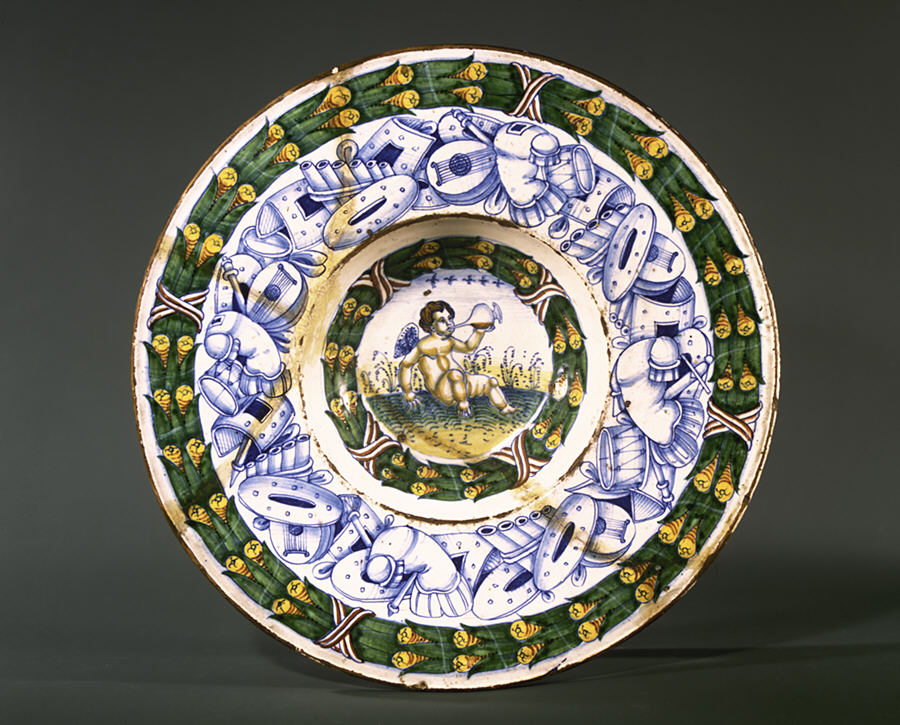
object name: plate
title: Plate (tondino)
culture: italian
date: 1530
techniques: maiolica, glazing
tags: musical instruments,putti,drinking